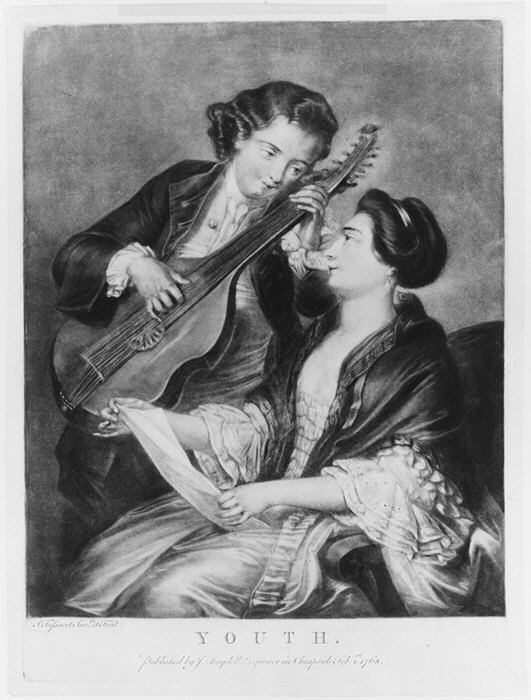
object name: print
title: Youth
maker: phillip joseph tassaert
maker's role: artist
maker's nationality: flemish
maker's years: 1732-1803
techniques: hand coloring, mezzotint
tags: musical instruments,men,women,music